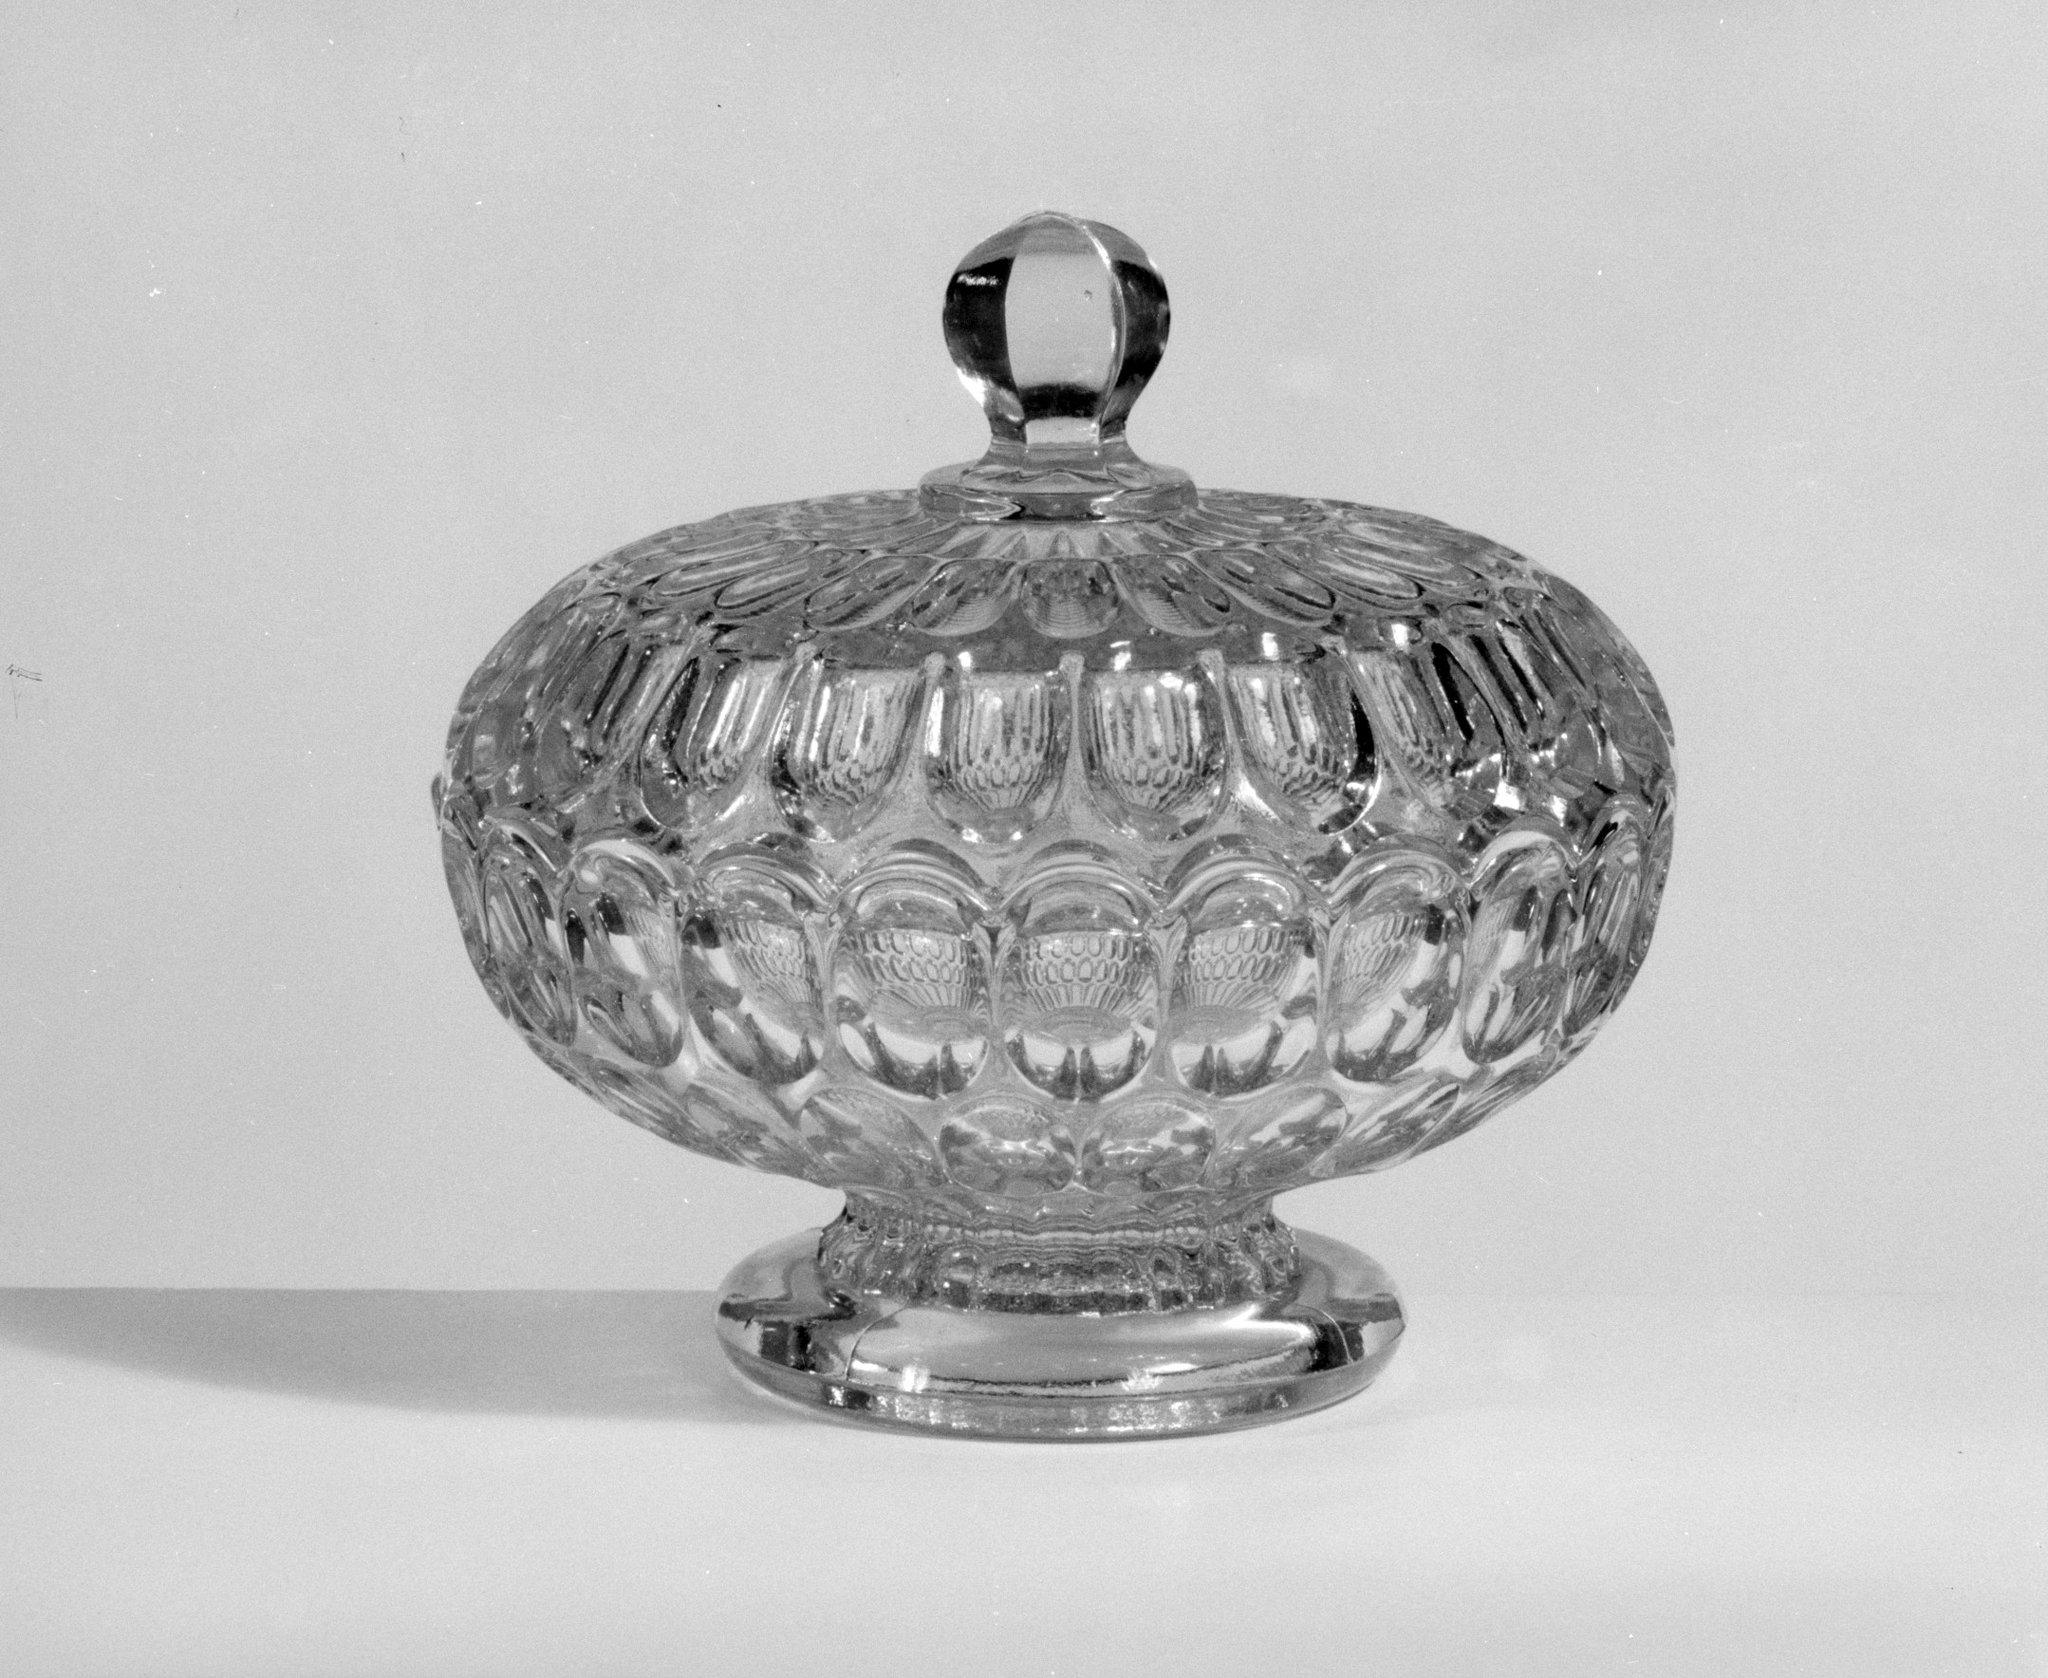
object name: butter dish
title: Covered Butter Dish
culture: american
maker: bakewell, pears and company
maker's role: maker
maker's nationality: american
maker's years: 1836-1882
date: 1850-1870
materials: glass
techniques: pressed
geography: united states